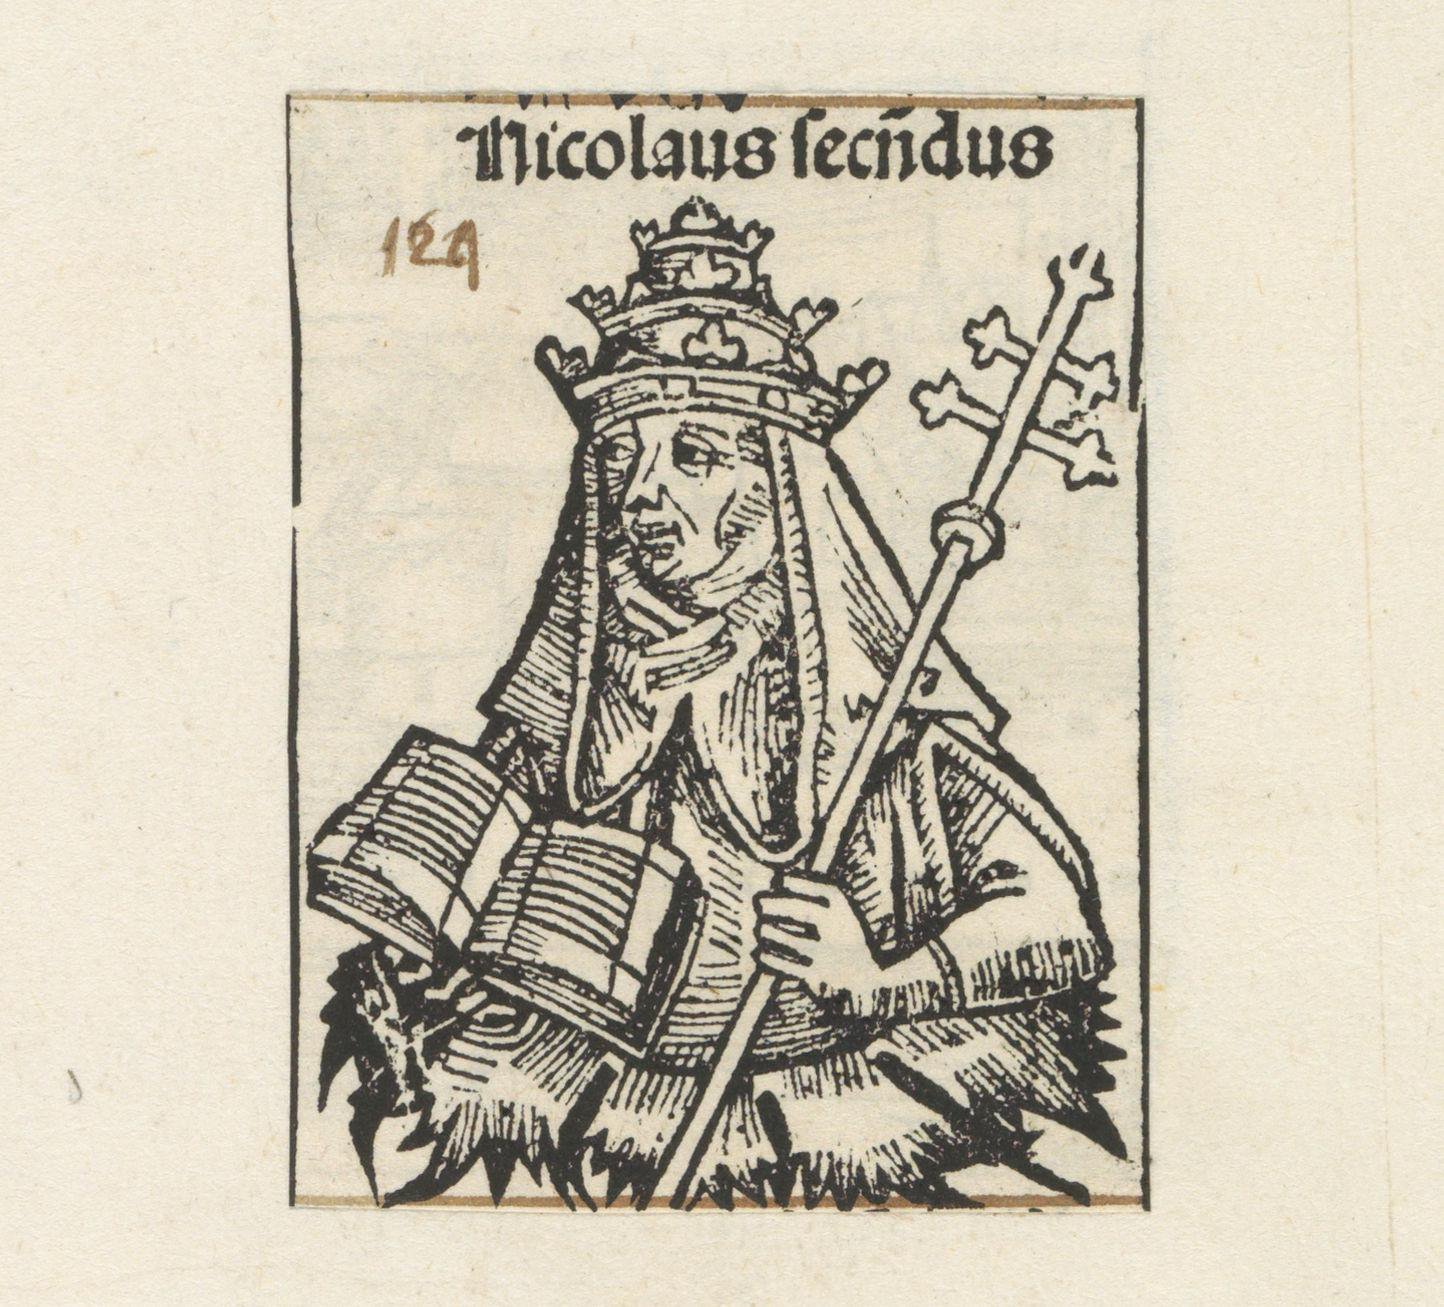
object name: book illustration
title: Nicolaus secu[n]dus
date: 1493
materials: paper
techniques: letterpress printing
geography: nuremberg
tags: pope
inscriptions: inscription: ‘124’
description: Een bloemkelk met een paus. Hij draagt een tiara en heeft een opengeslagen boek en een staf met een dubbel kruis in zijn handen. De voorstelling is onderdeel van de opeenvolging pausen in de Liber Chronicarum. De tekst identificeert de man als Nicolaas II. De prent maakt deel uit van een album.